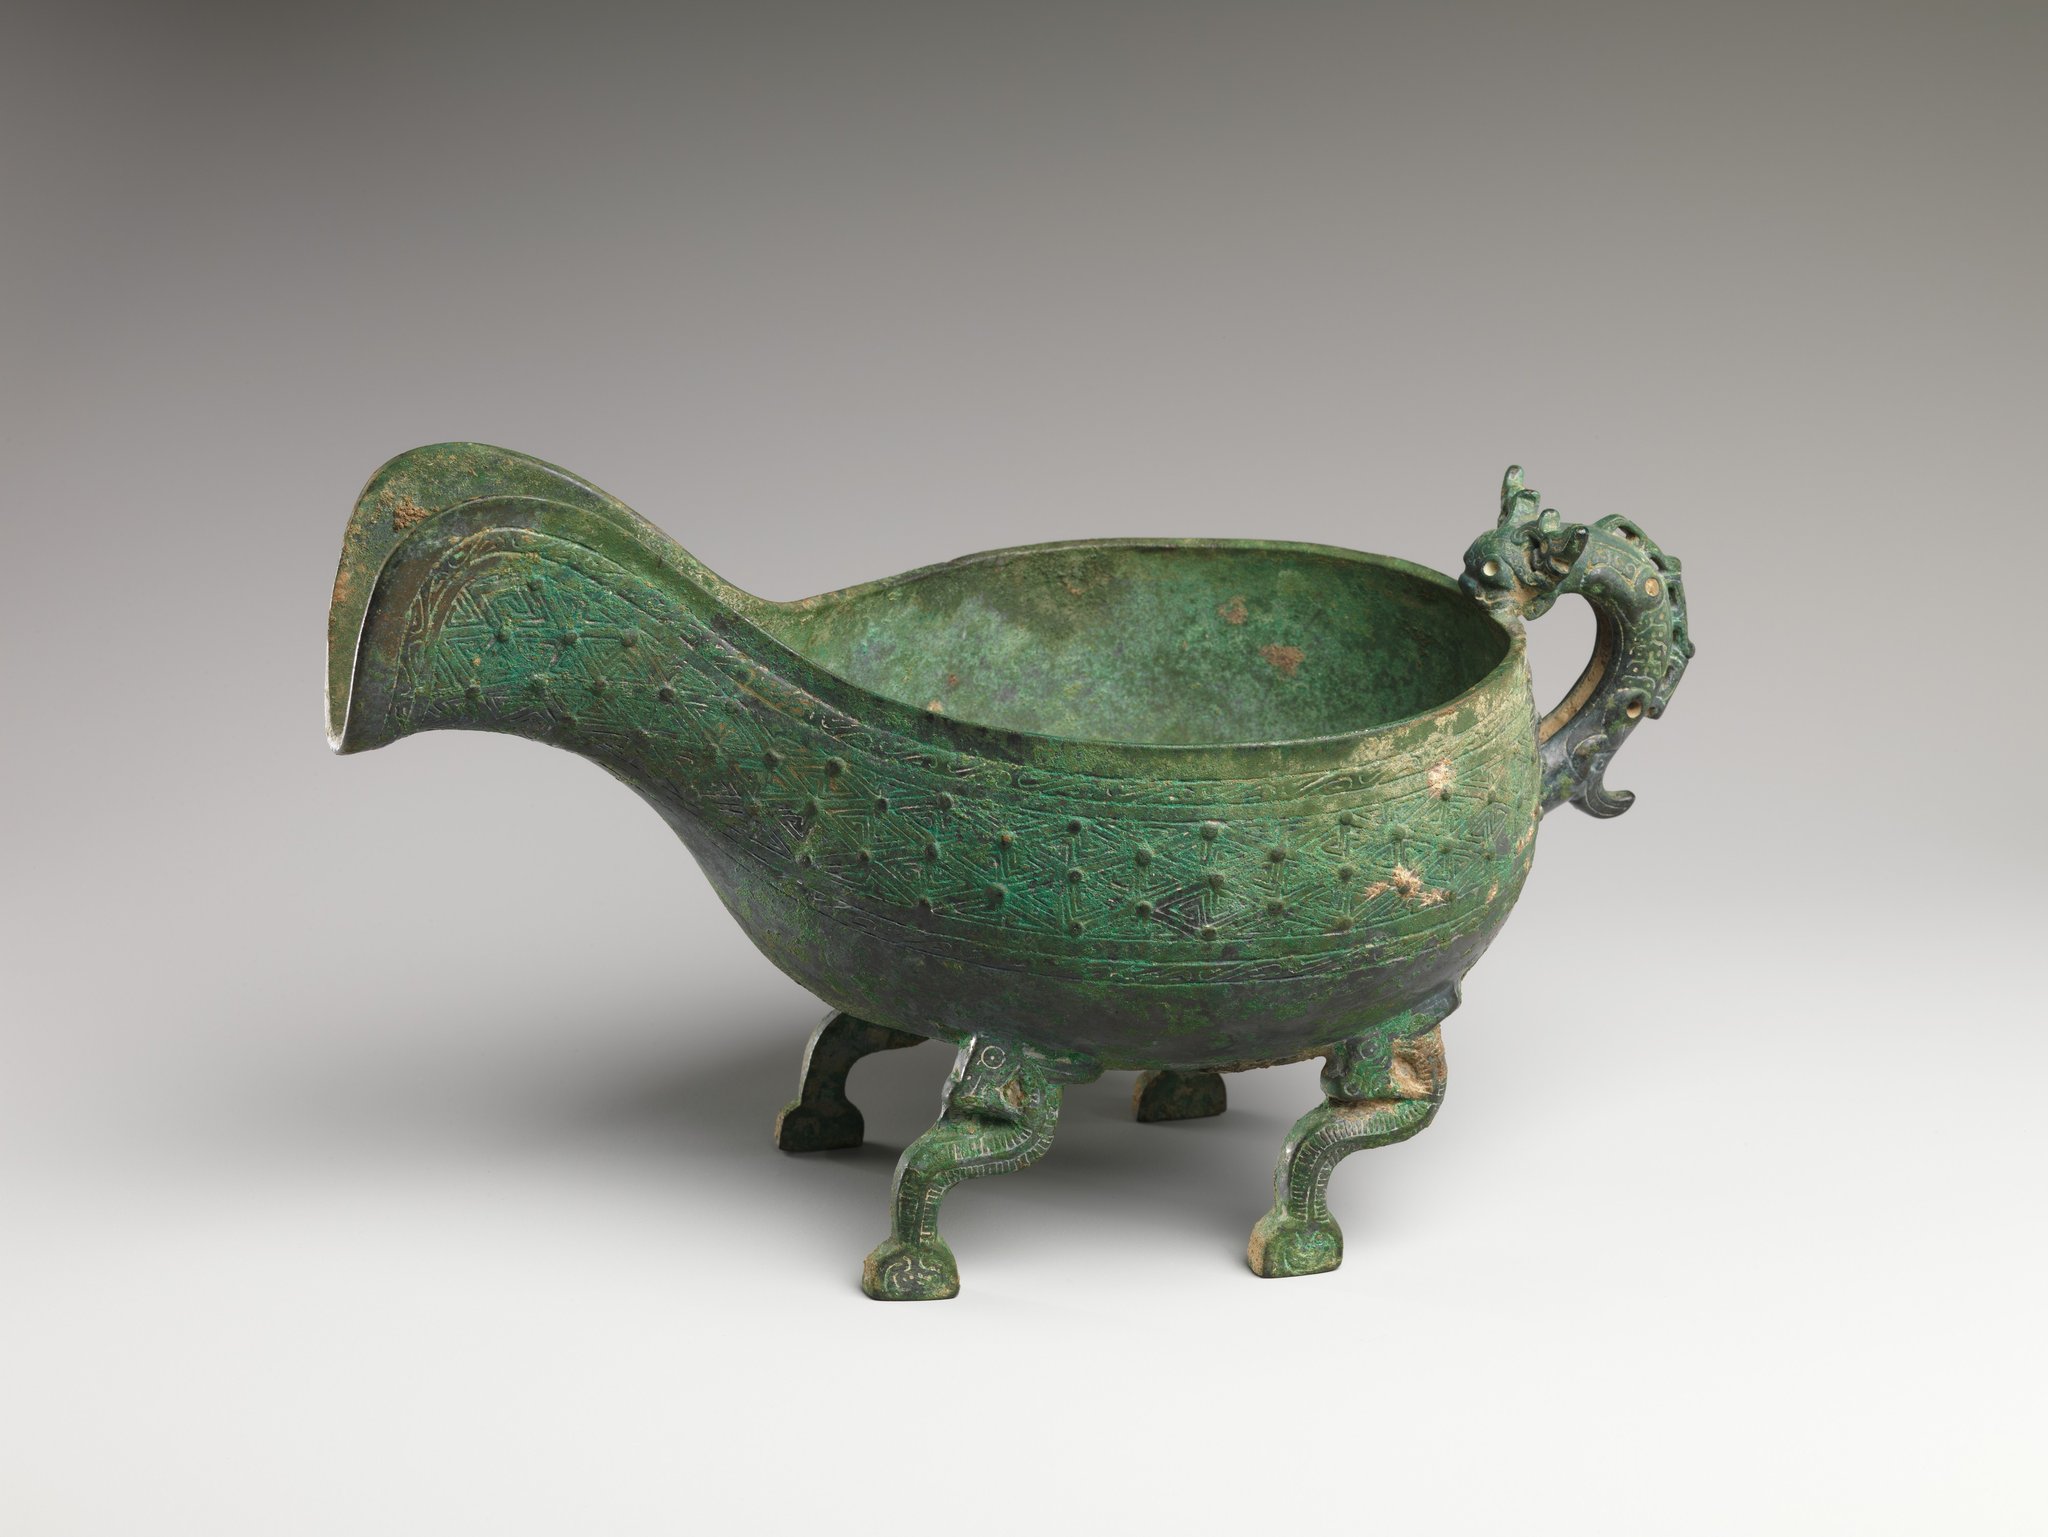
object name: vessel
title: Spouted Water Vessel (Yi)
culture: chinese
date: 700-501 BCE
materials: bronze